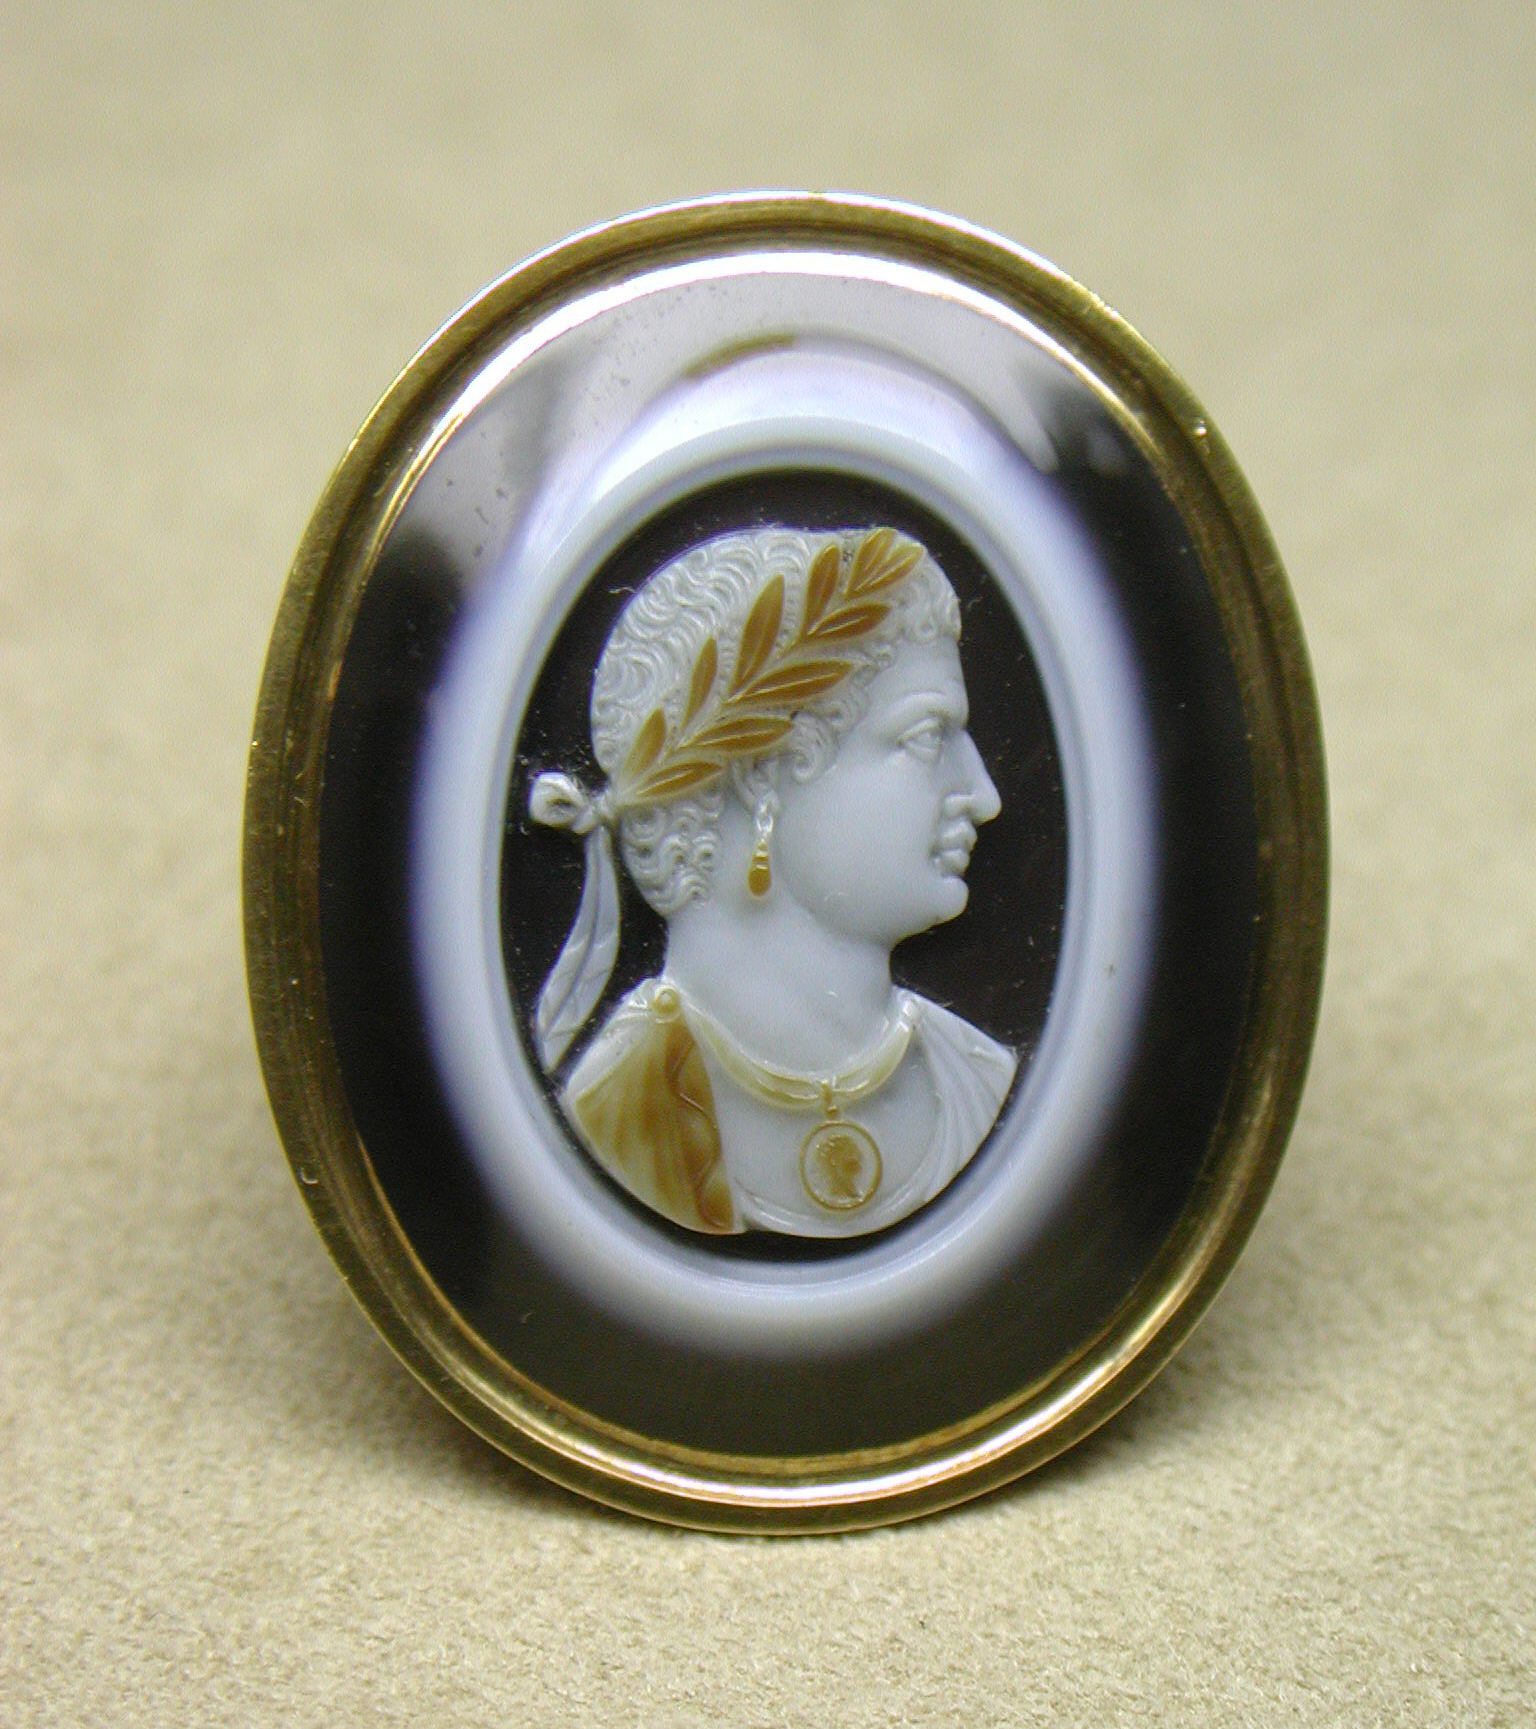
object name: cameo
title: Bust of a Roman Emperor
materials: gold, gemstone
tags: men,profiles